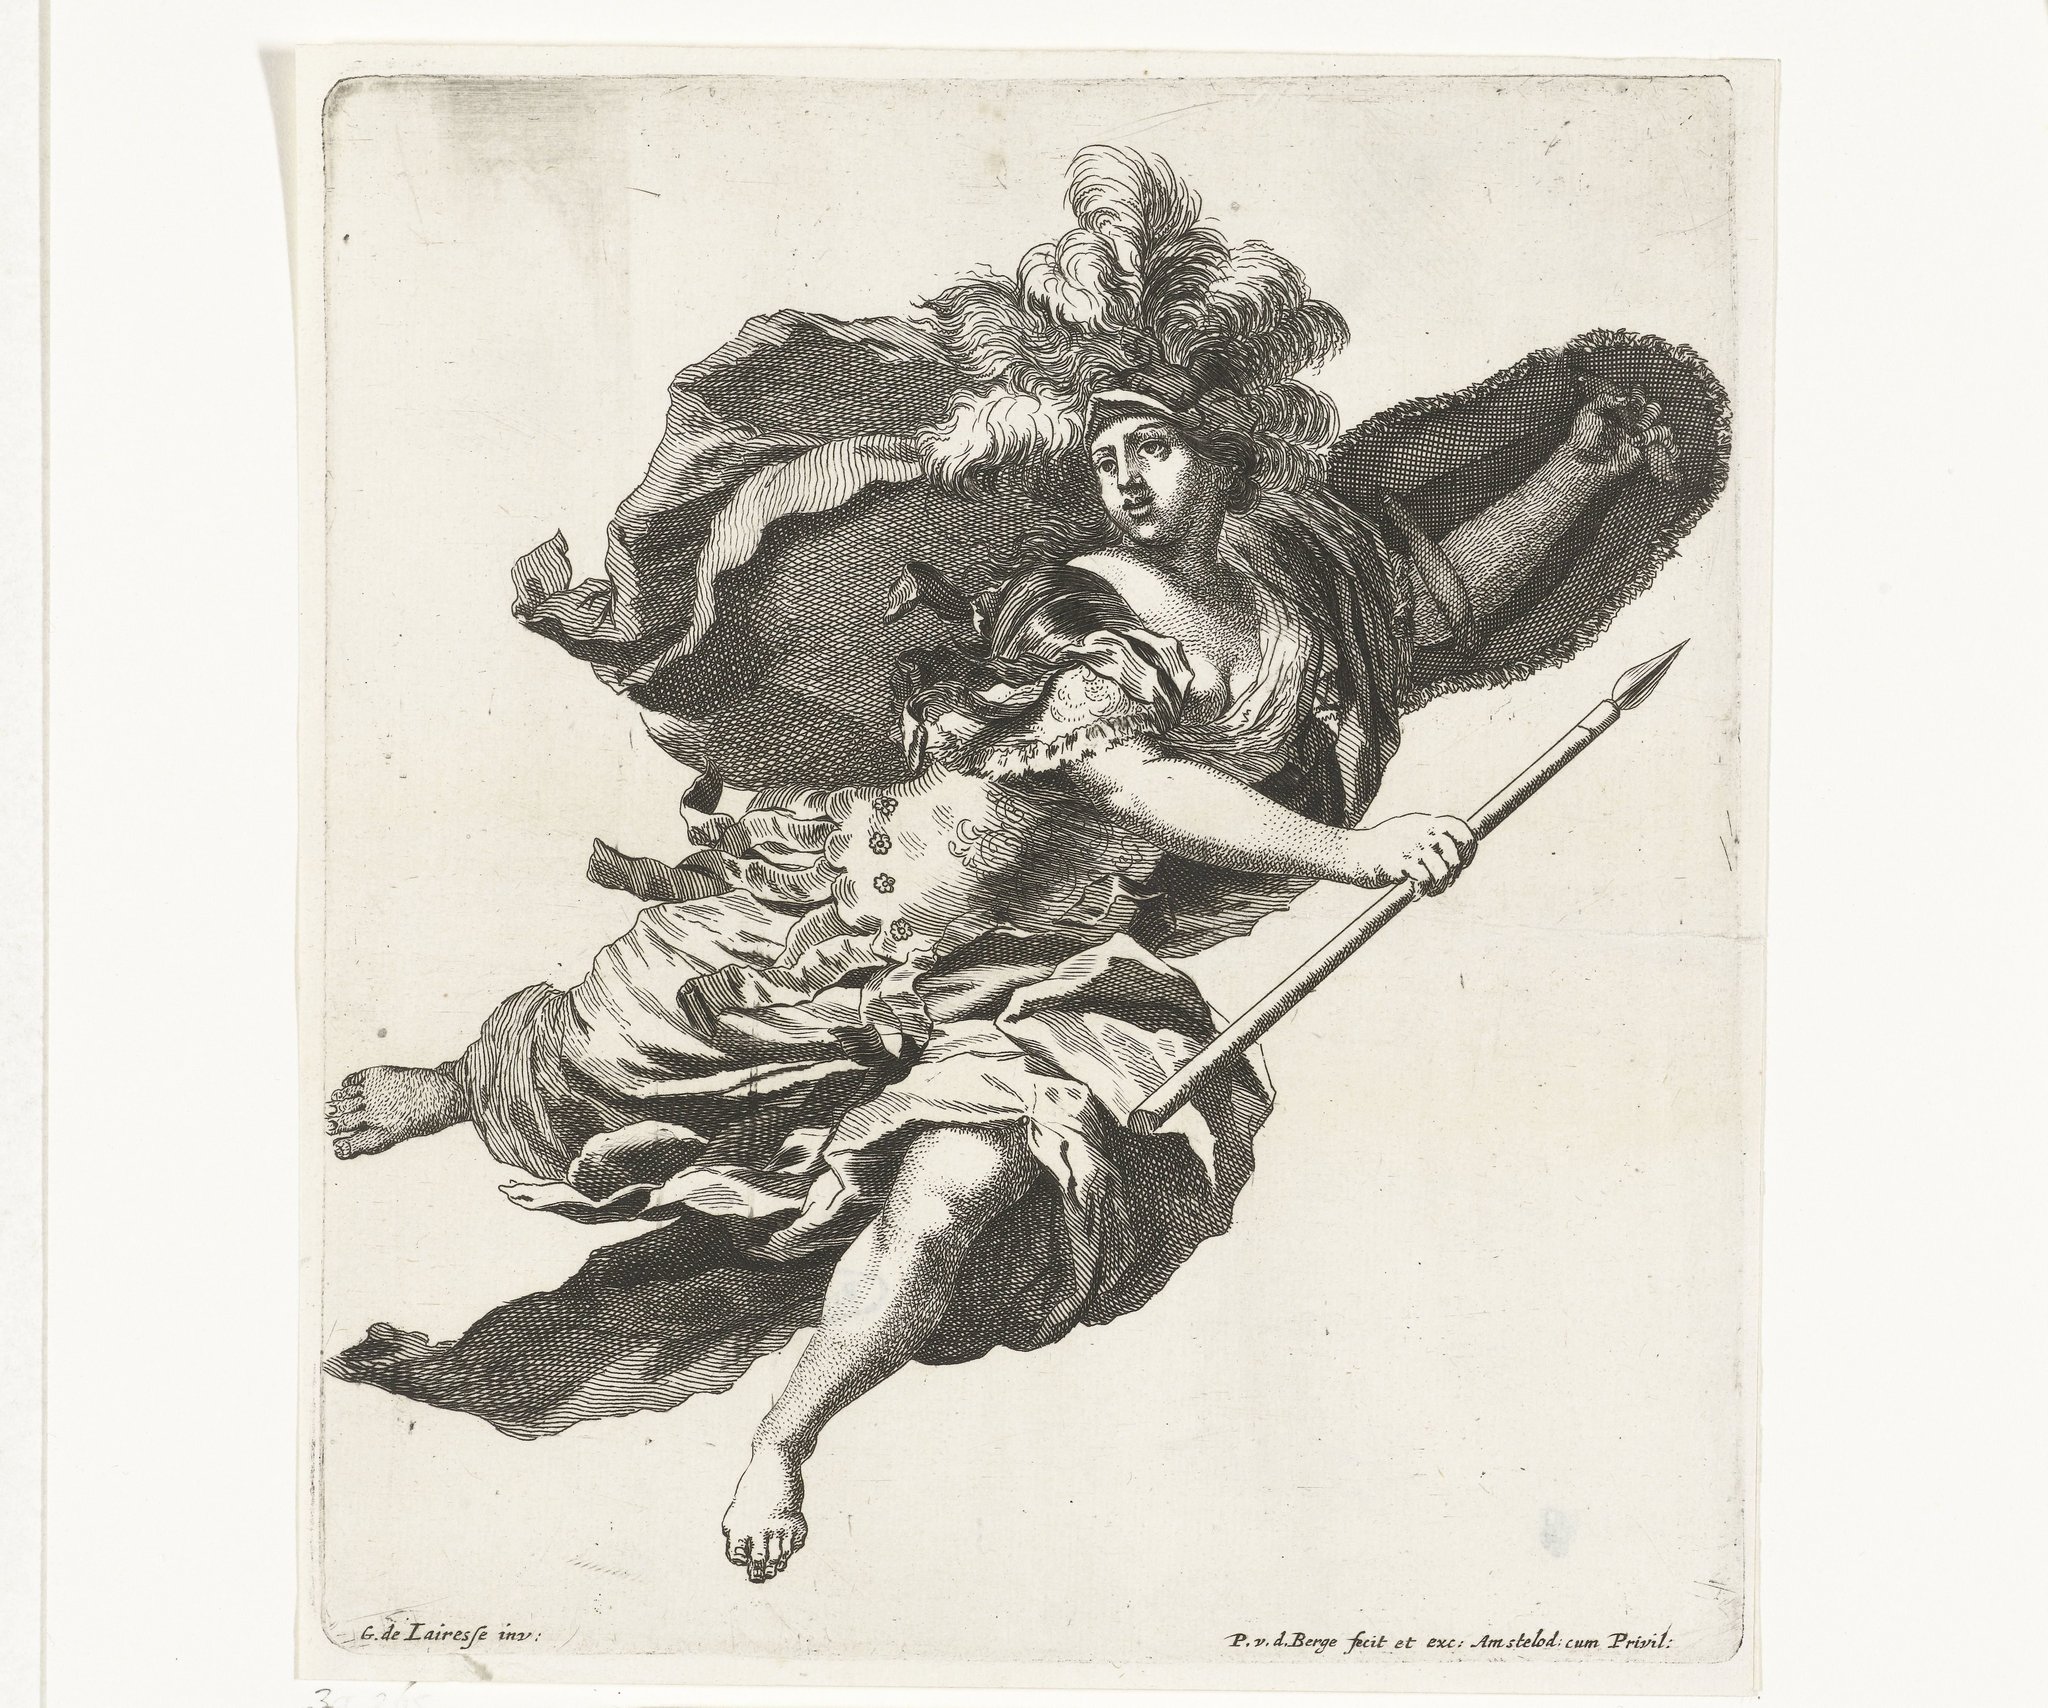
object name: print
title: Minerva vliegend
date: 1694-1737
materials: paper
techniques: engraving, etching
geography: amsterdam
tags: (story of) minerva (pallas, athena)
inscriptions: collector's mark: Lugt 2228, collector's mark: Lugt 2760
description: Minerva met helm en harnas, gewapend met een speer en een schild, vliegend.